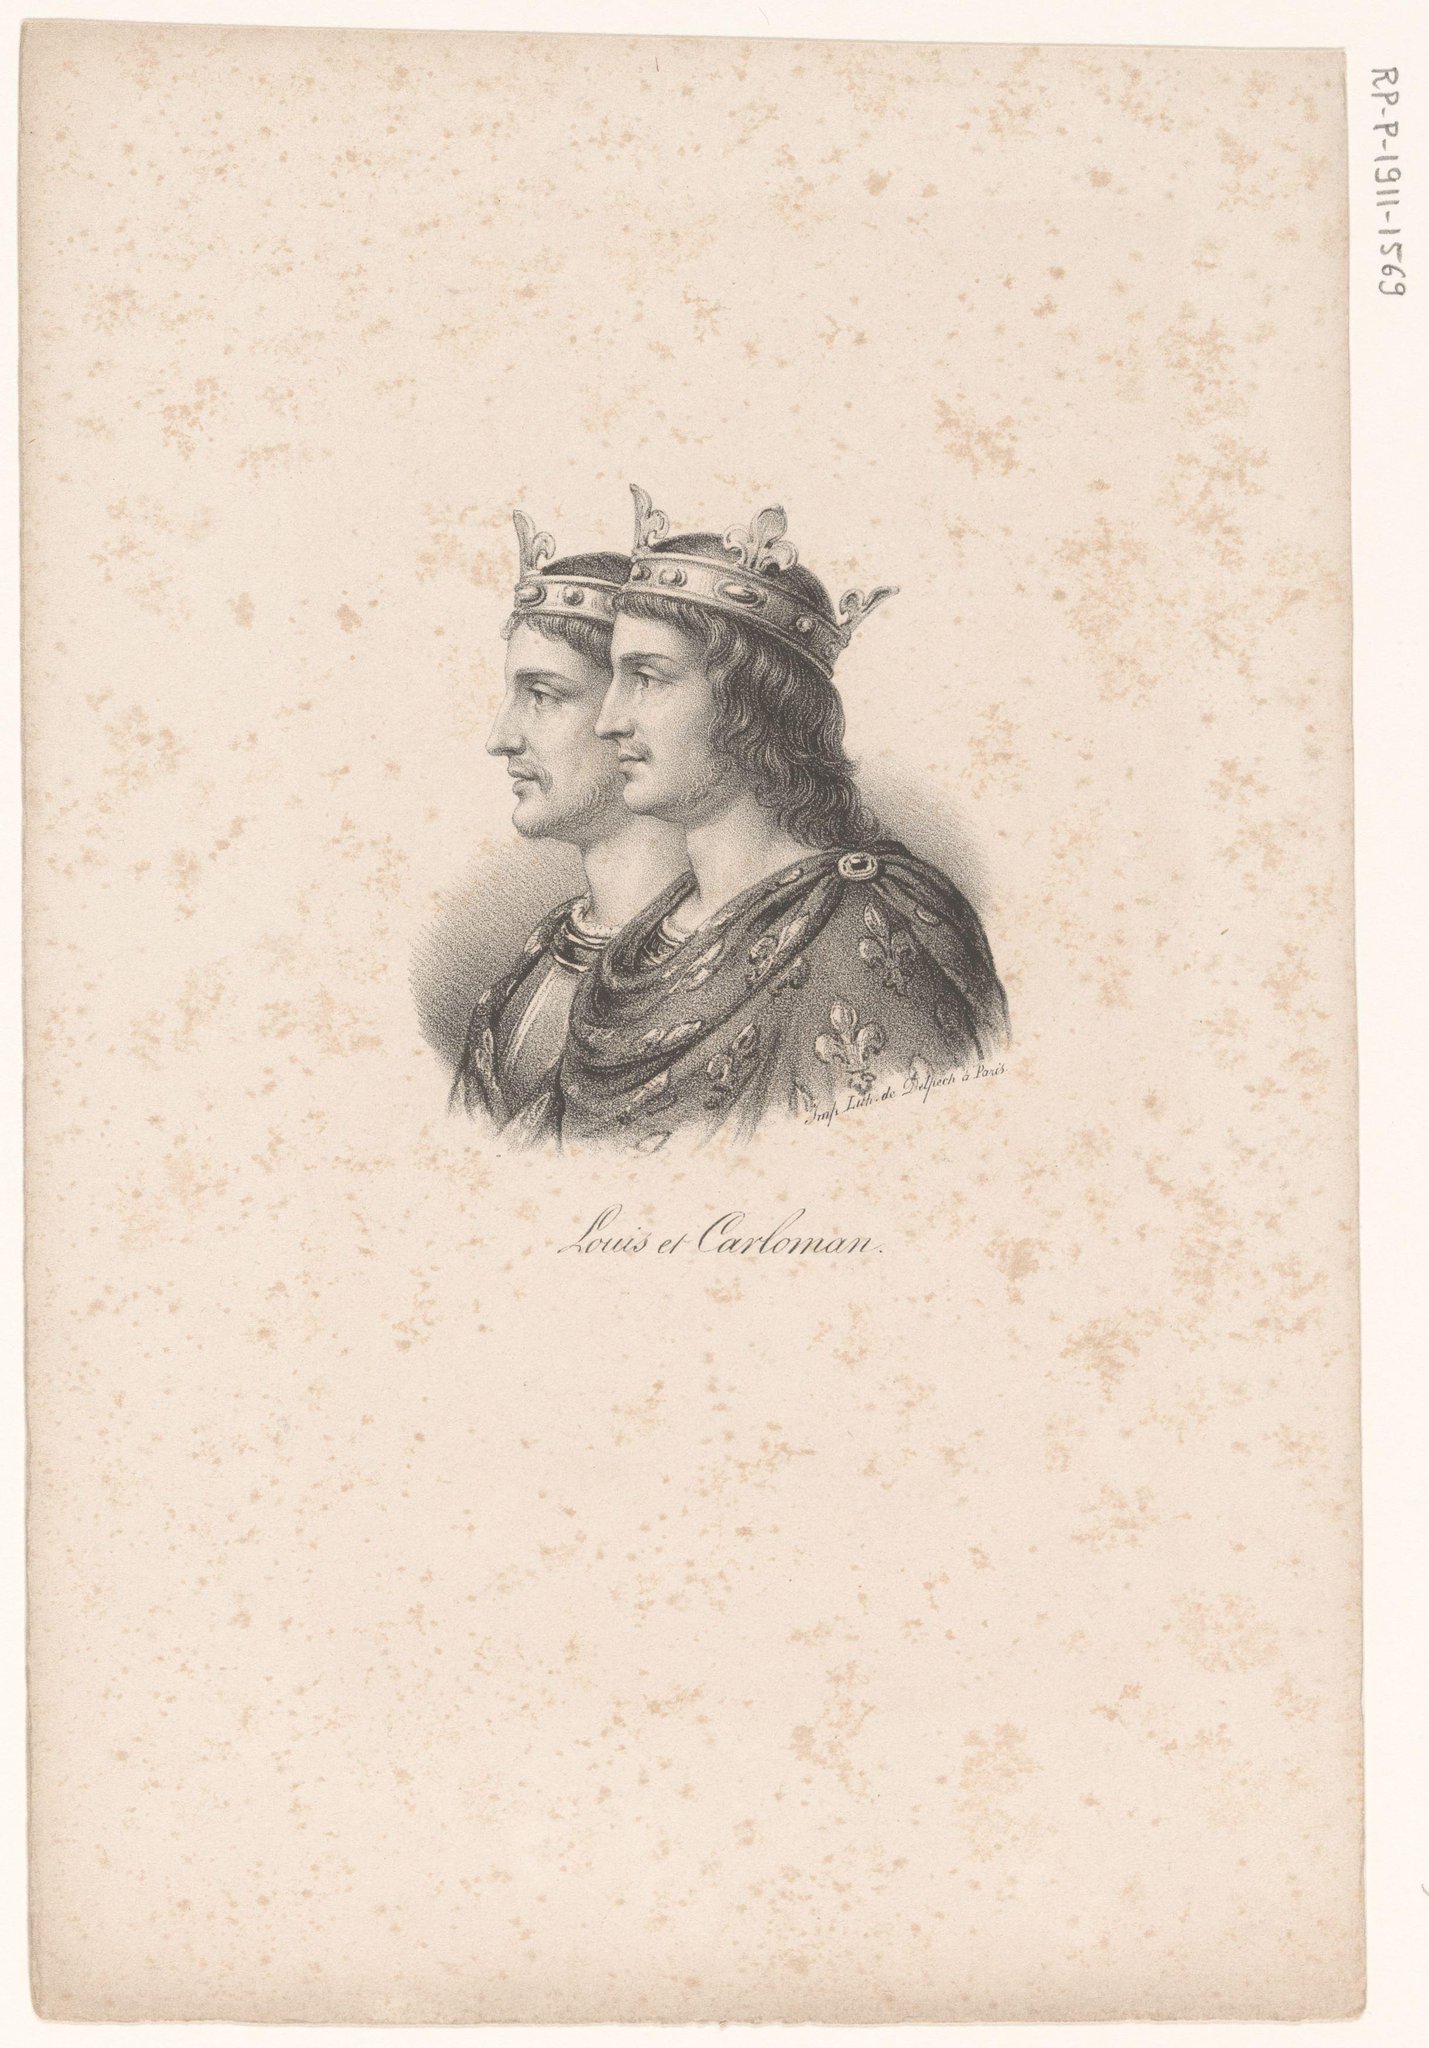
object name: print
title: Louis et Carloman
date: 1818-1842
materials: paper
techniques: lithograph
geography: paris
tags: historical persons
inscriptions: collector's mark: Lugt 2228a